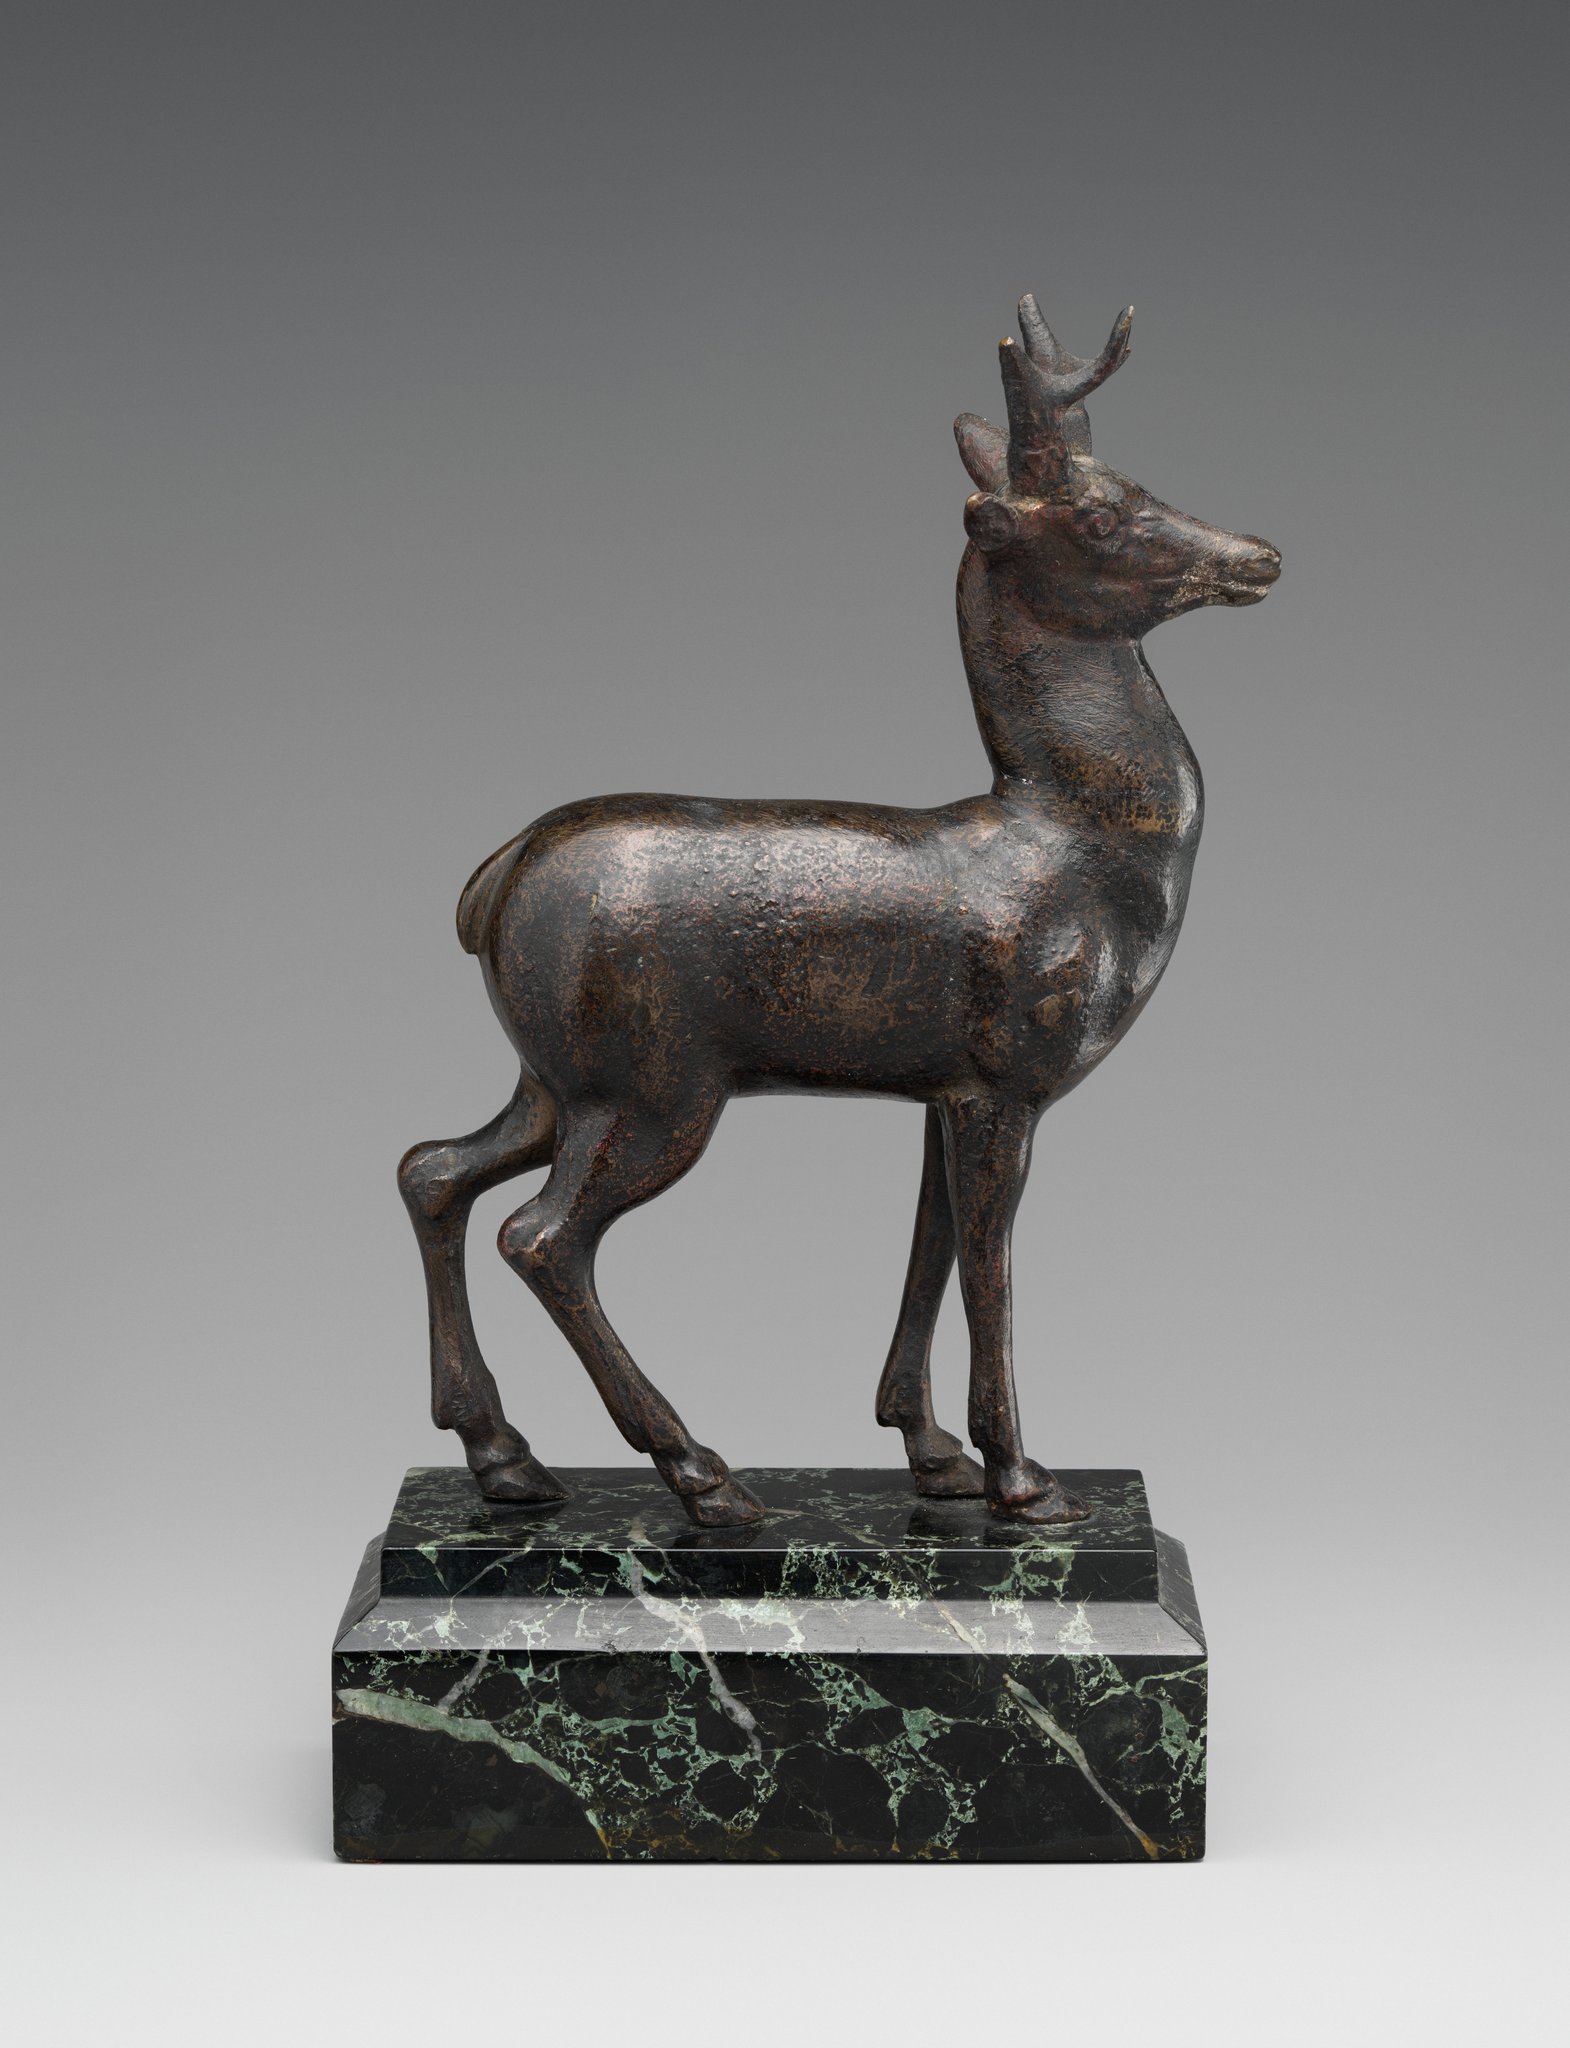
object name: statuette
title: Deer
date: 1467-1500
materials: bronze, marble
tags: deer